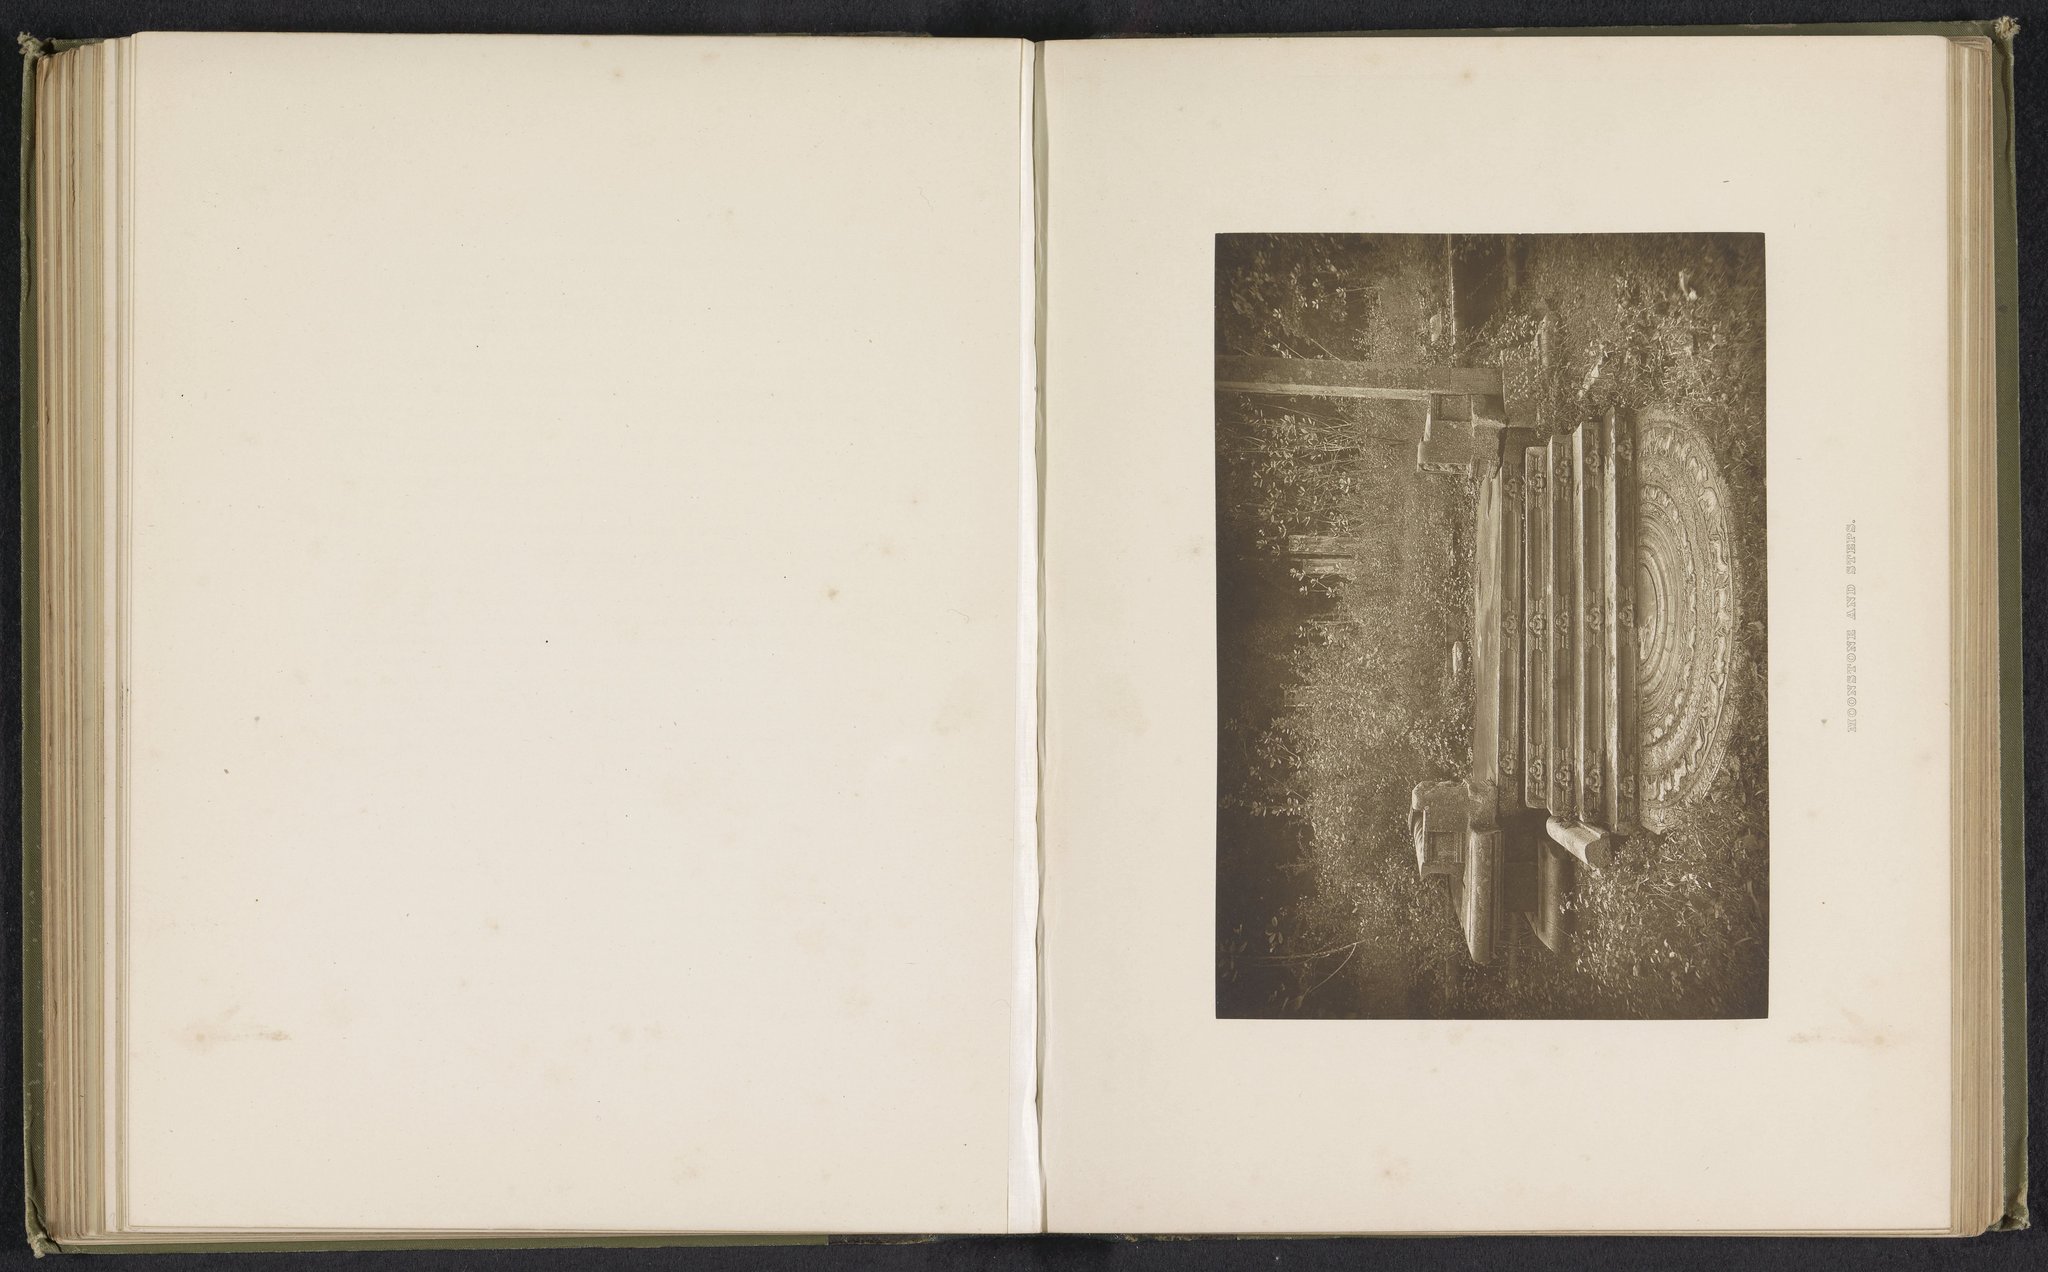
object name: photomechanical print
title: Moonstone and steps in front of the palace of King Mahasena at Anuradhapura, Sri Lanka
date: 1896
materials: paper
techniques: woodburygravure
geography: anuradhapura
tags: flight of steps, sculpture (+ relief ~ sculpture)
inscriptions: title: ‘MOONSTONE AND STEPS.’